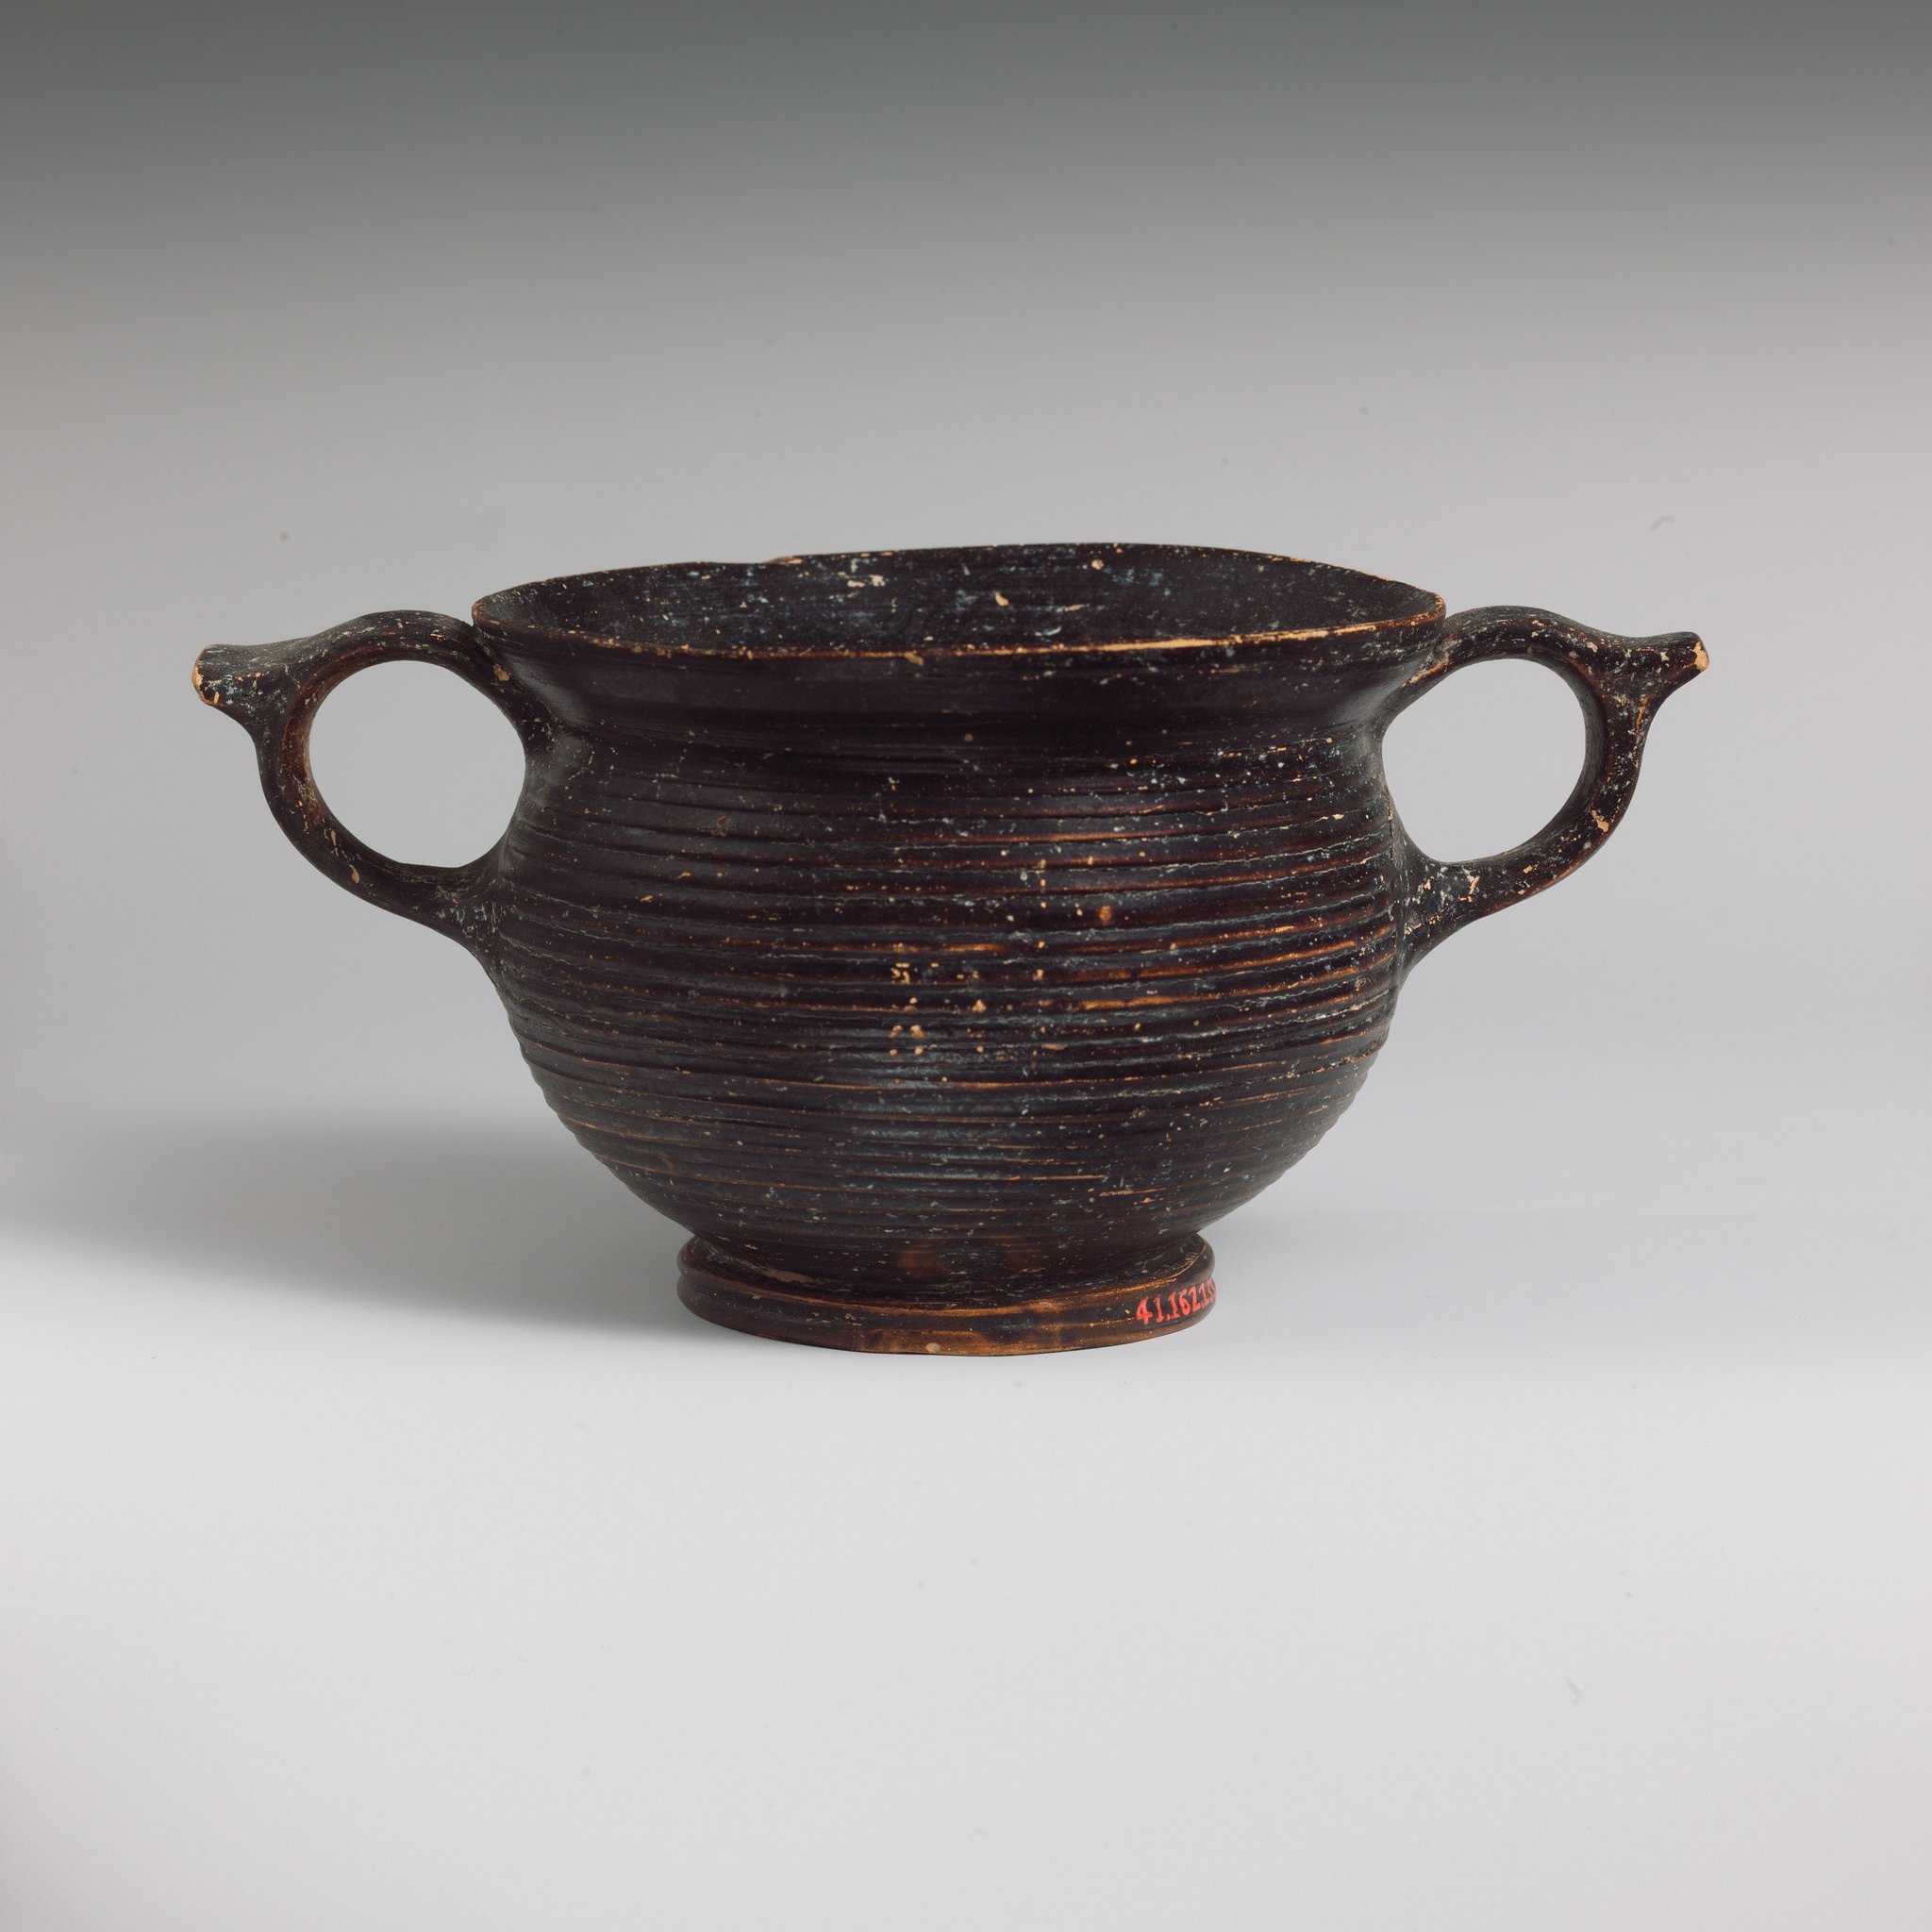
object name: kantharos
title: Terracotta kantharos (drinking cup) with vertical ring handles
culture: greek, boeotian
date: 400-301 BCE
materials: terracotta